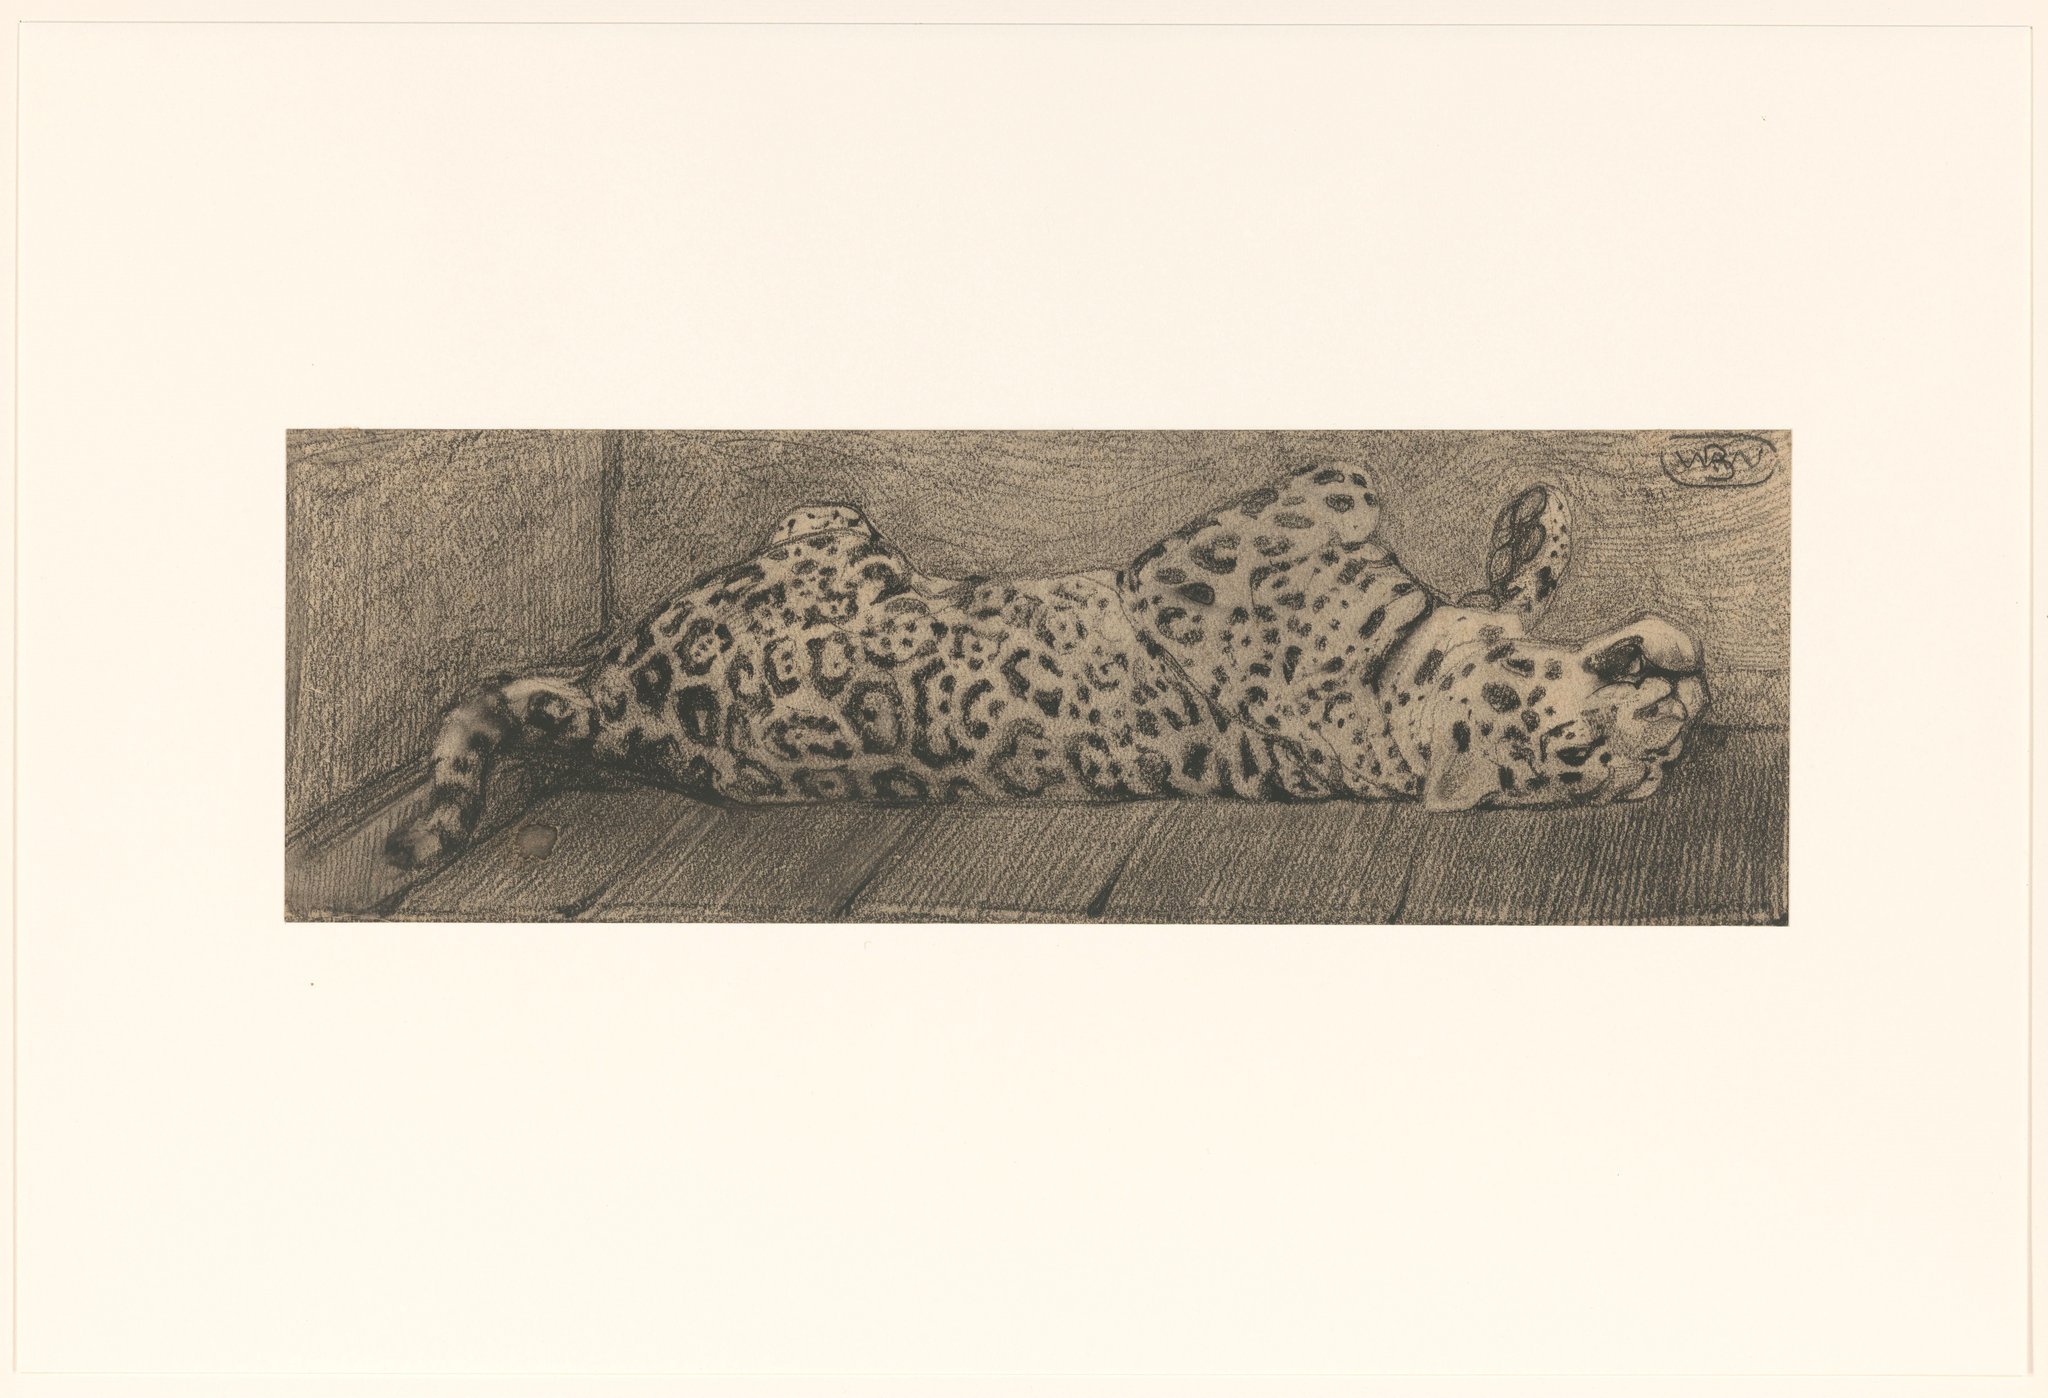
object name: drawing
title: Jaguar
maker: bernard willem wierink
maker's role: draughtsman, print maker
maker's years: 1856-1939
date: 1866-1939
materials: chalk, paper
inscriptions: monogram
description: Jaguar die op zijn rug ligt met de poten naar boven.